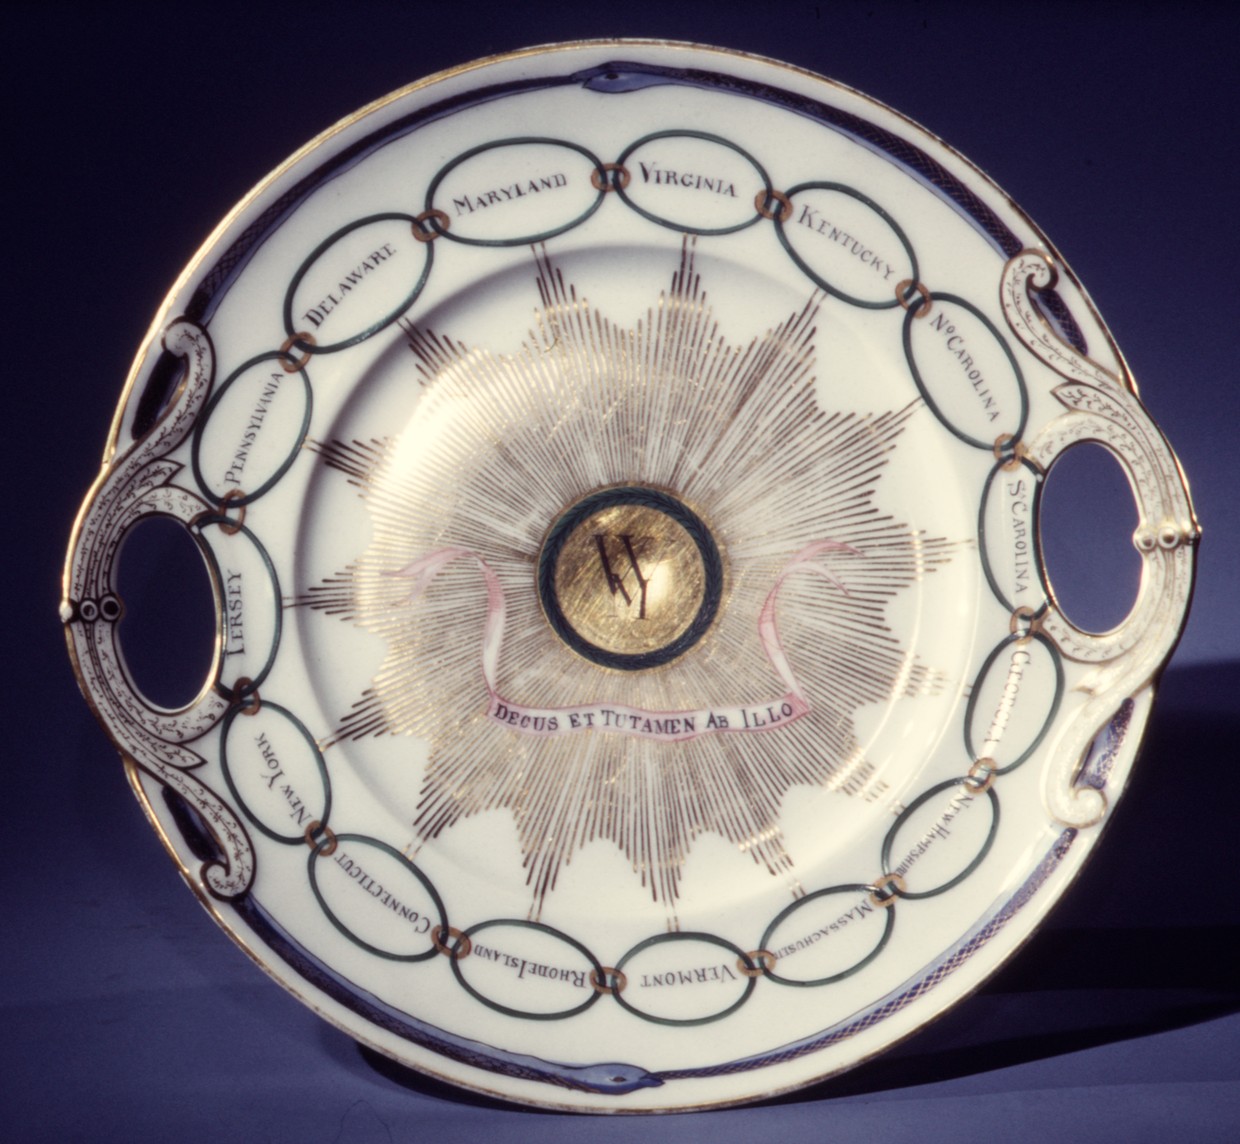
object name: cake plate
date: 1876-1900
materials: hard paste porcelain